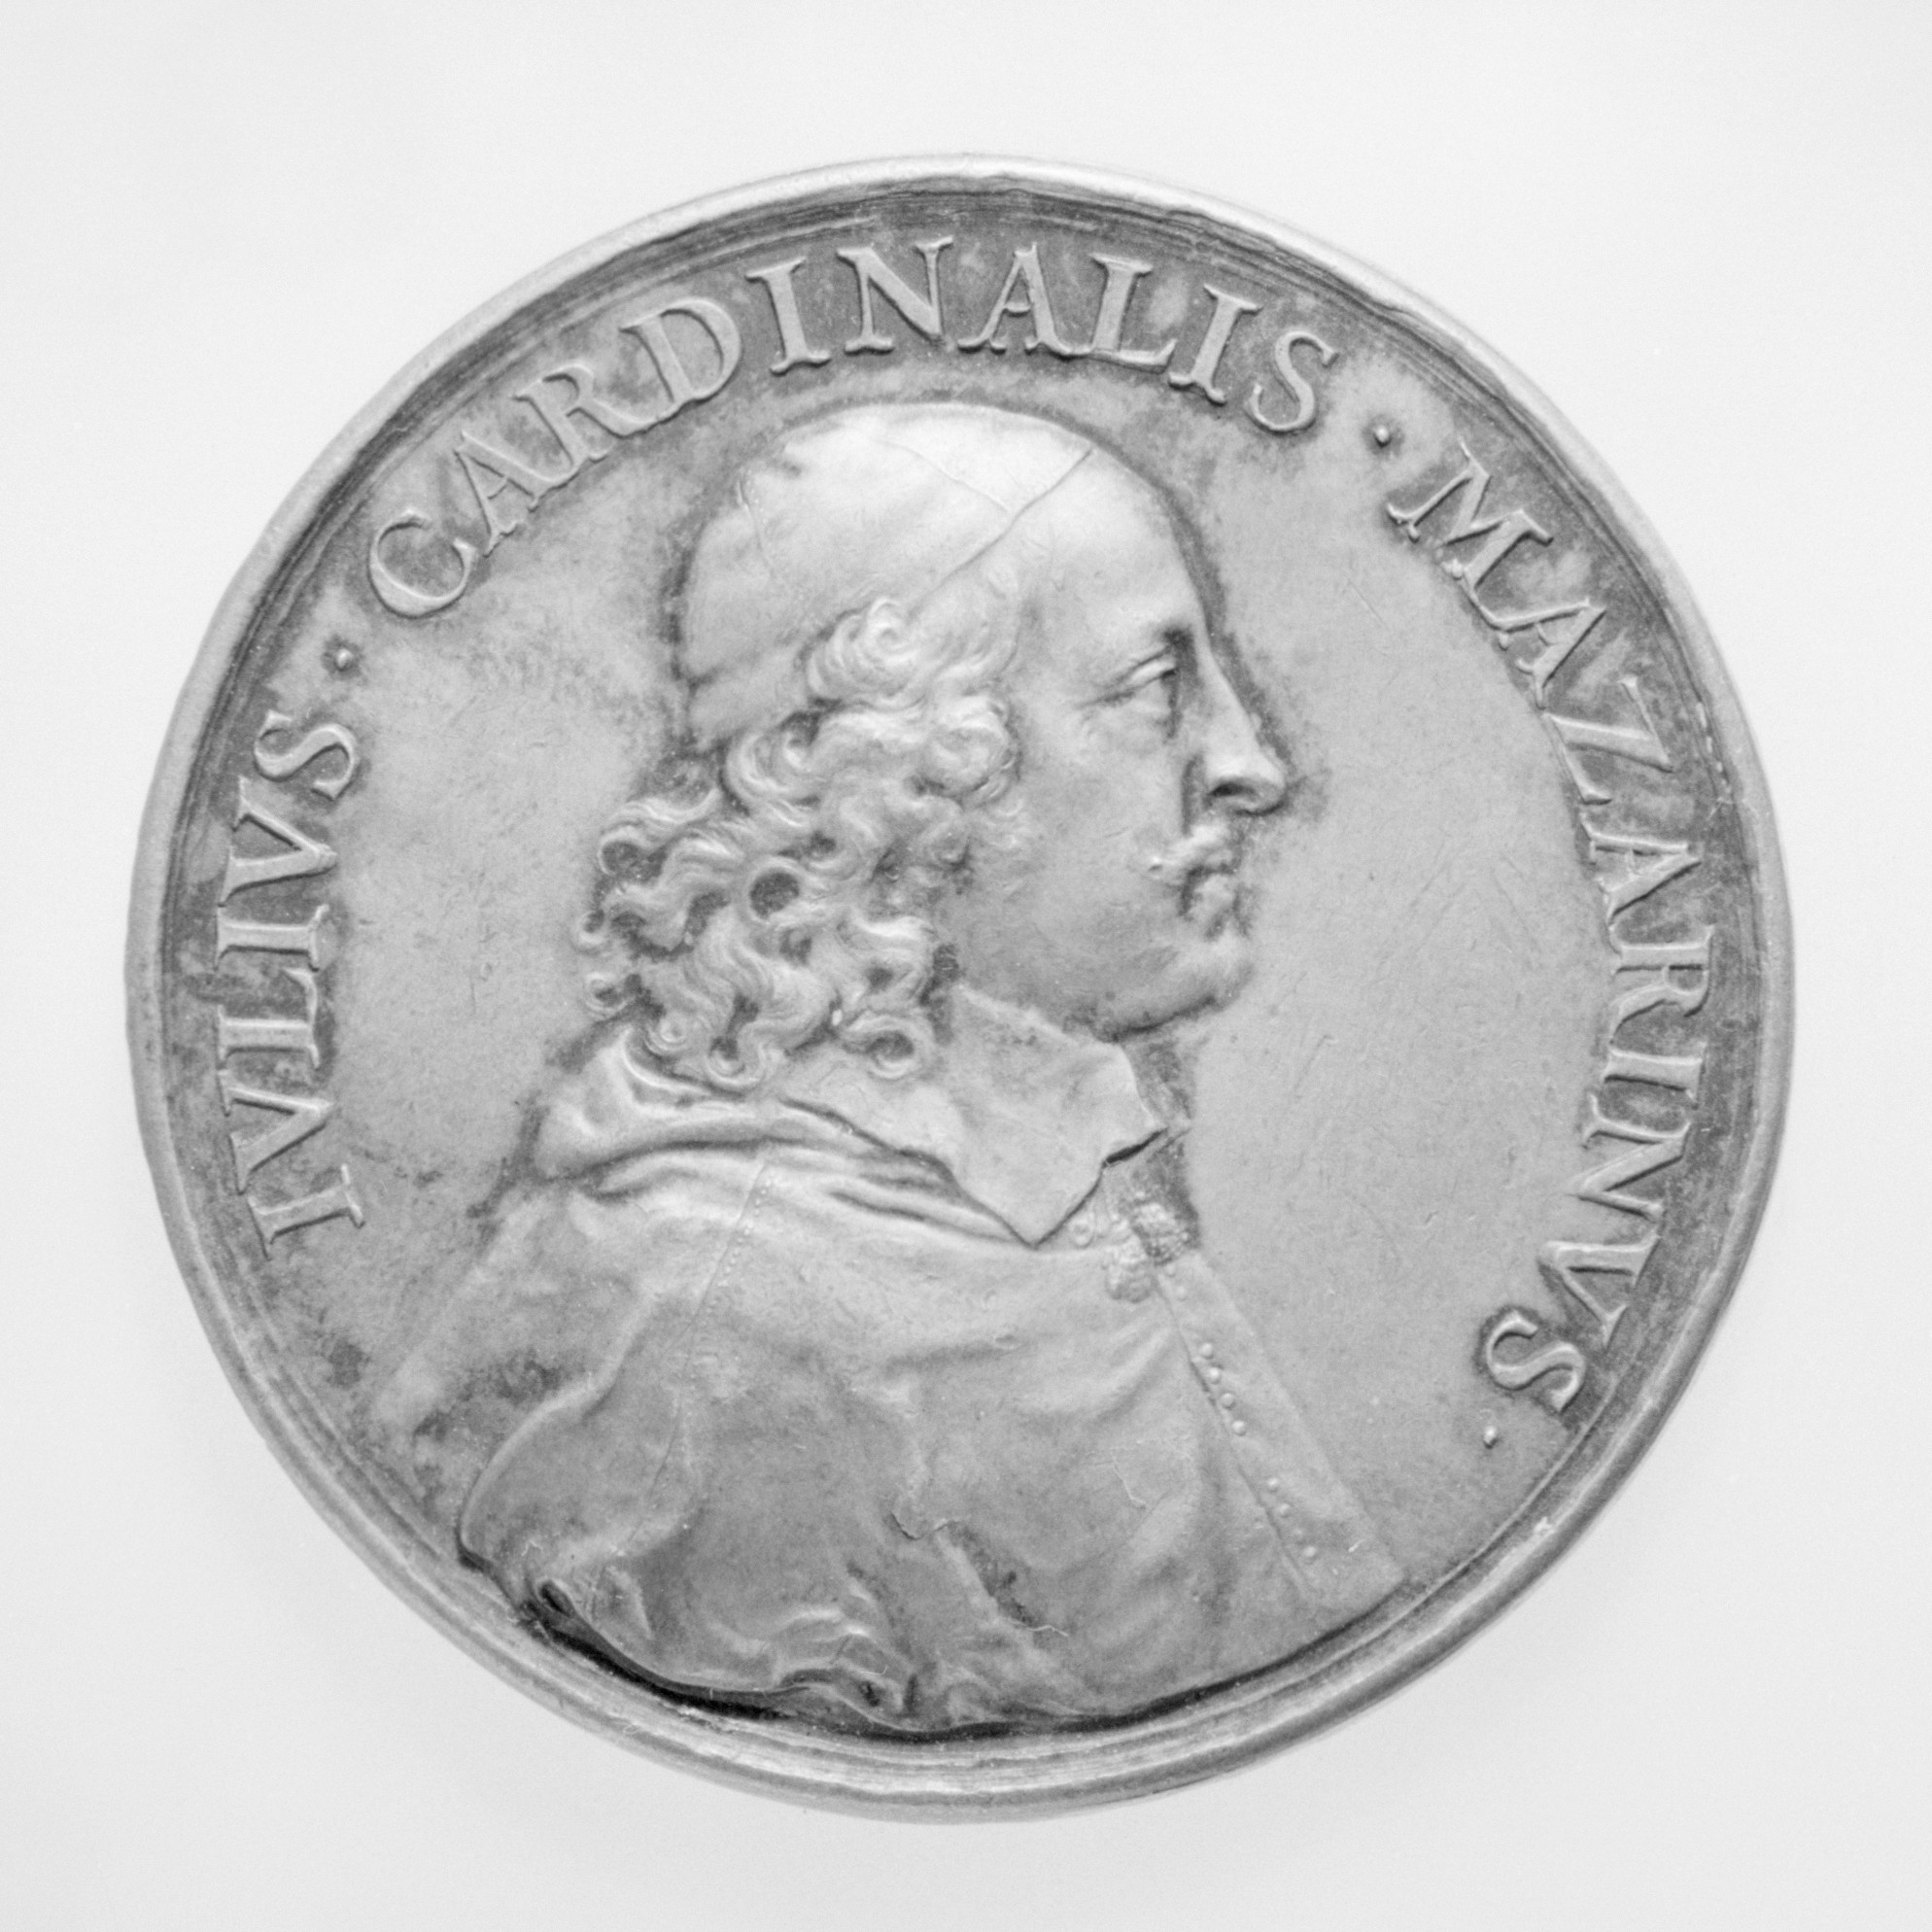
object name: medal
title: Cardinal Mazarin (1602–61)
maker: jean varin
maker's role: artist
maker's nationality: french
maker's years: 1606-1672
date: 1660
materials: silver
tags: men,profiles